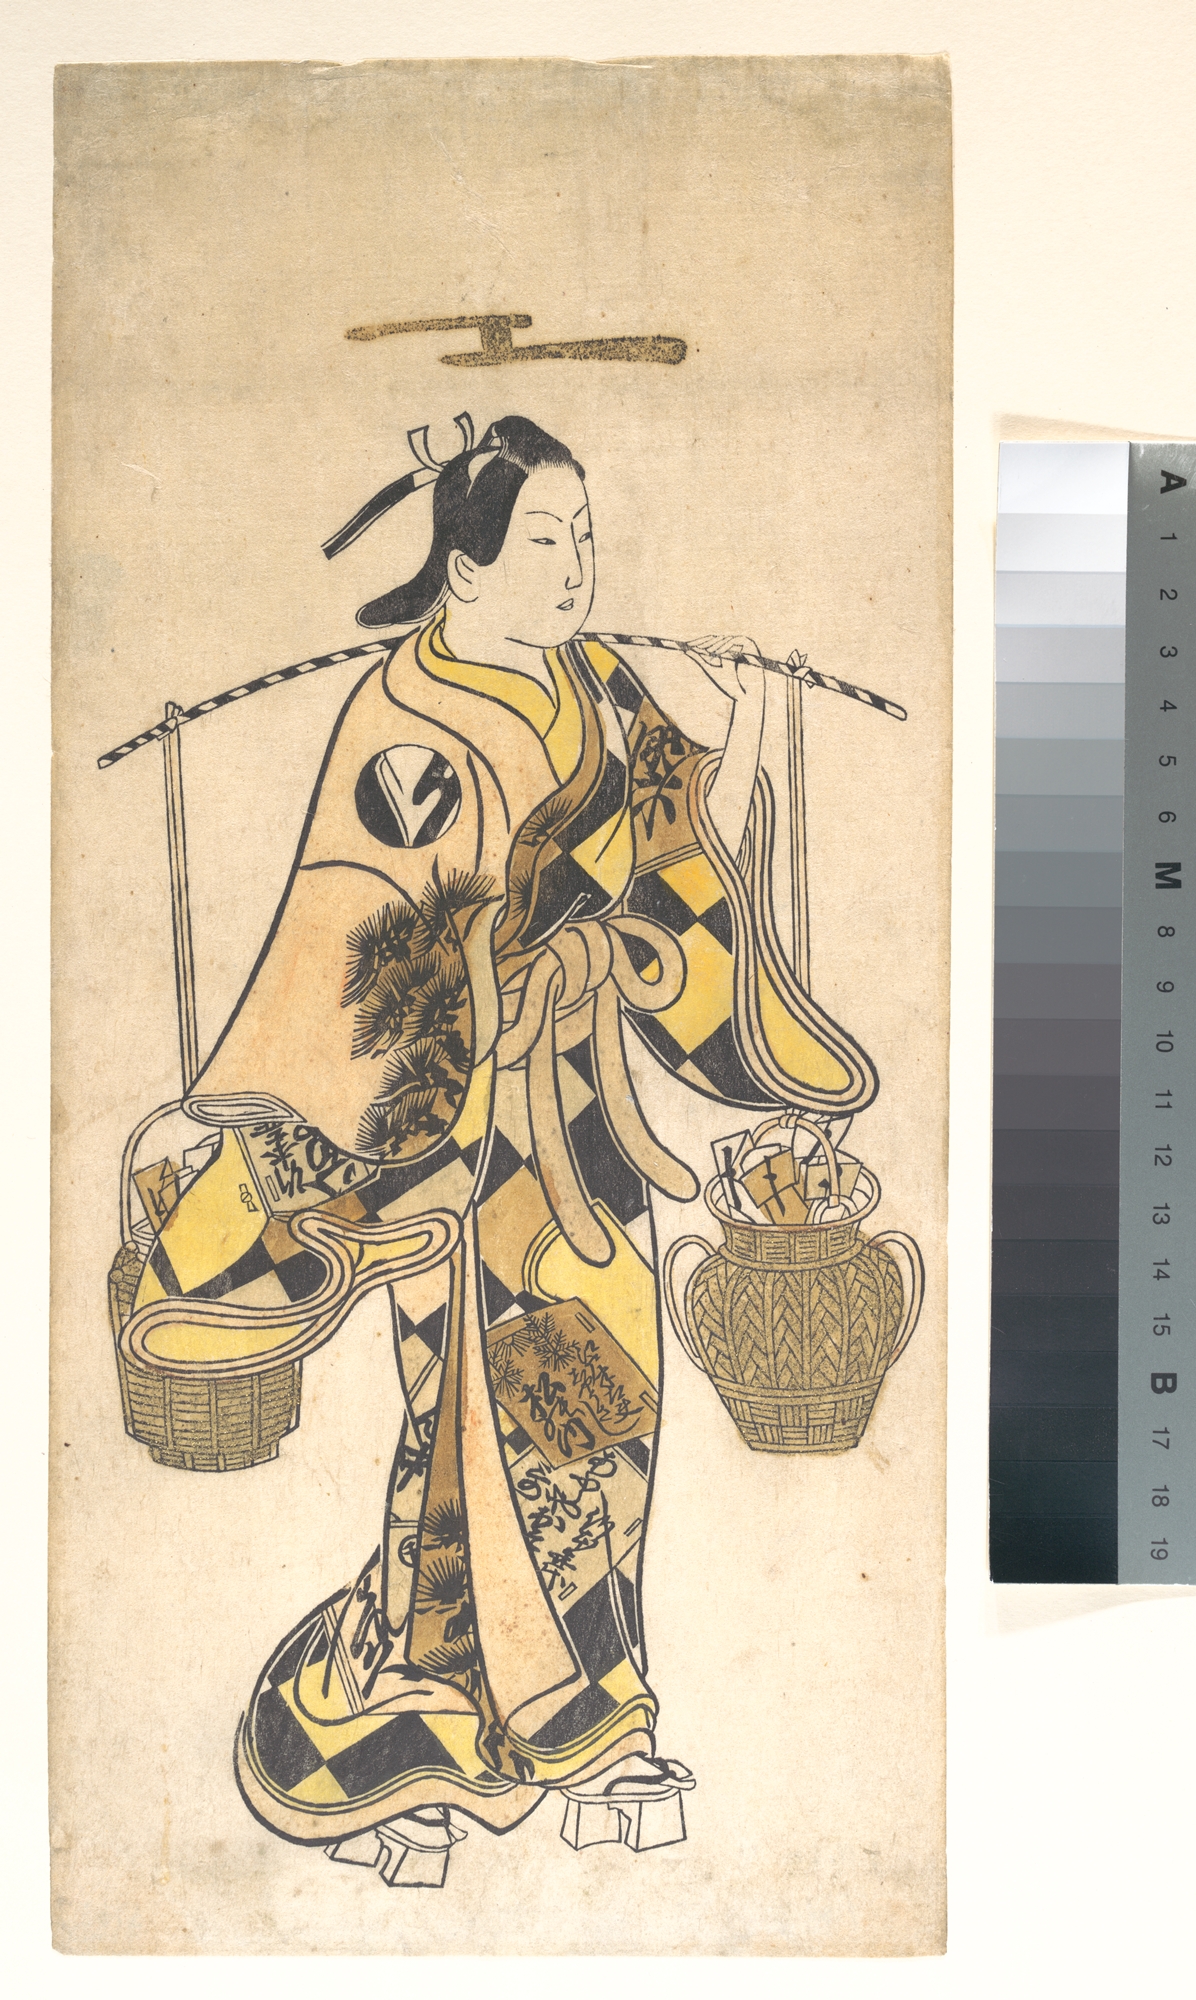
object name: print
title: A Young Man as a Seller of Love Prophecies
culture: japanese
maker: okumura toshinobu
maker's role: artist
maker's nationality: japanese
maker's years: 1717-1750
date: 1730-1739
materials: ink, paper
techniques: hand coloring, woodblock print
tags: men